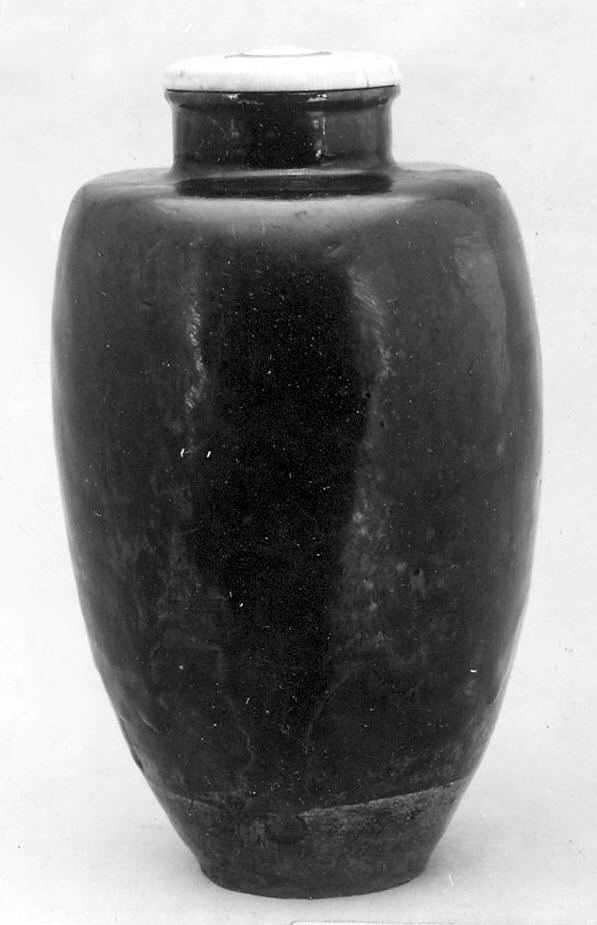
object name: tea jar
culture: japanese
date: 1801-1900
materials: paste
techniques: overglaze